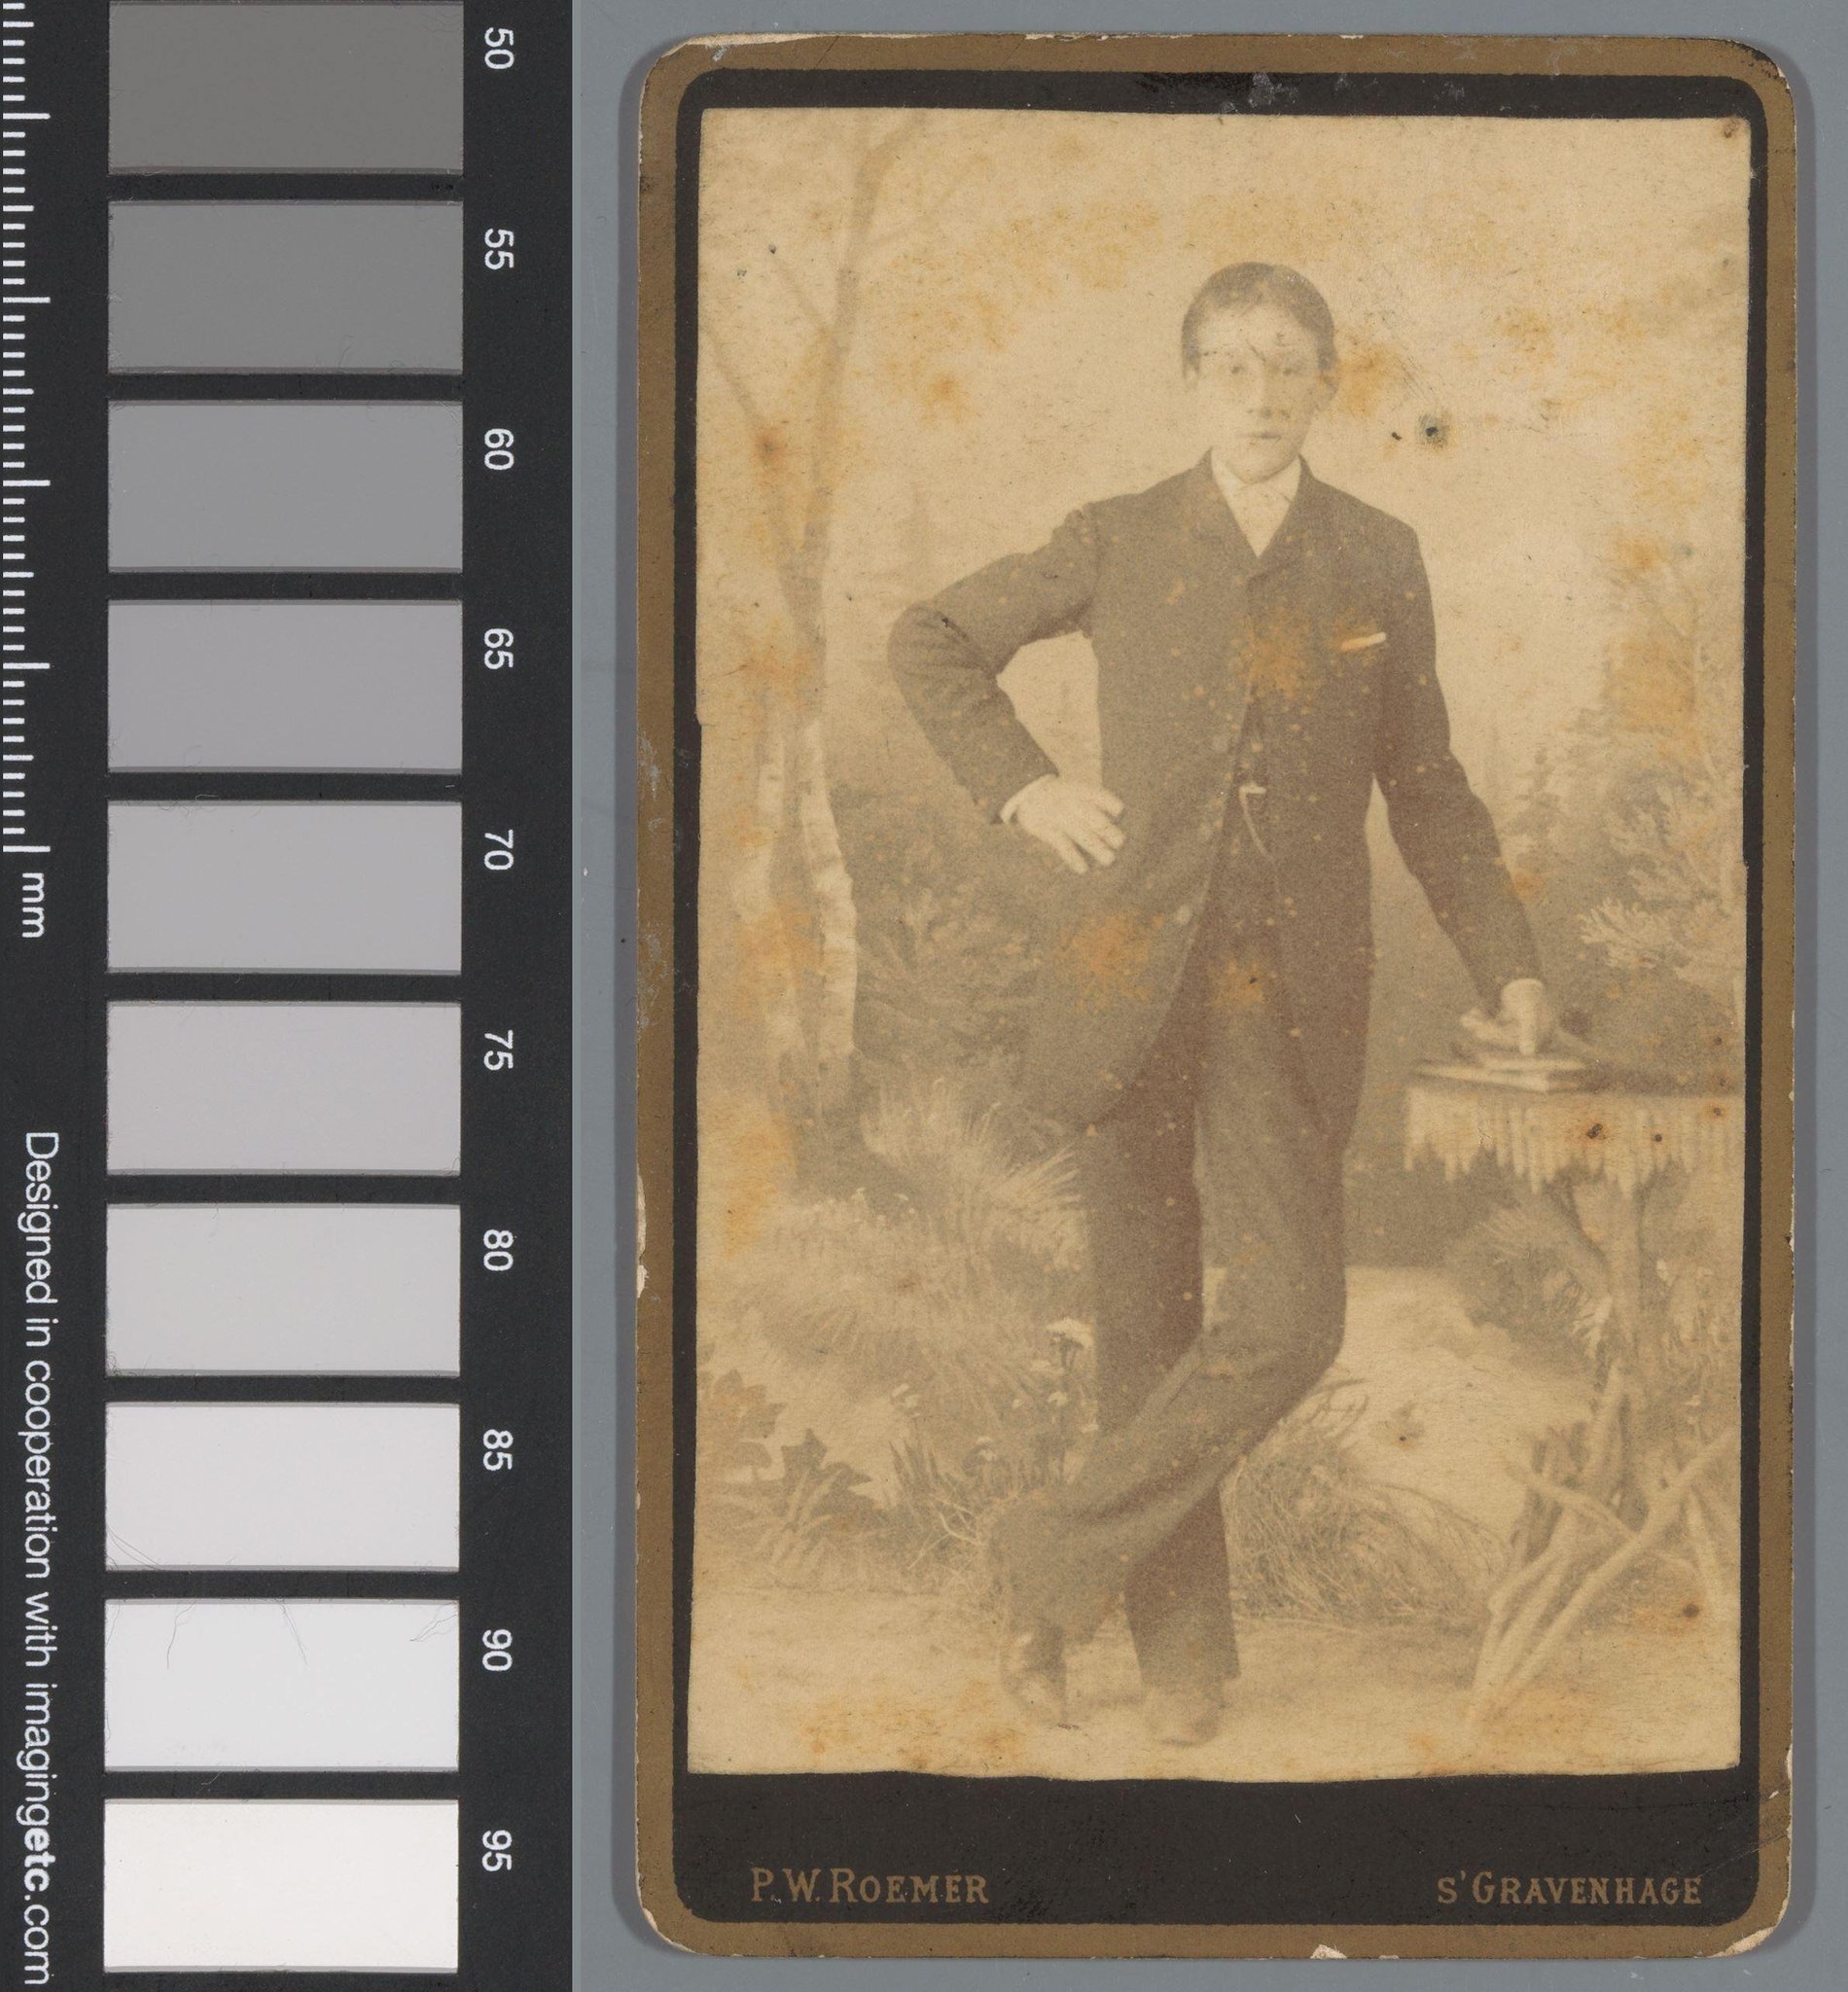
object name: carte de visite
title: Portret van een onbekende man, staande naast een tafel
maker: pieter wilhelmus roemer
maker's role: fotograaf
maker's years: 1838-1924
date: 1864-1910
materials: cardboard, paper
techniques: albumen print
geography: the hague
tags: historical persons, youth, adolescent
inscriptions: inscription: ‘PWR/ PHOTOGRAPHIE ARTISITQUE/ van/ P. W. ROEMER/ Passage No. 22/ bij de Spuistraat,/ S GRAVENHAGE./ Specialiteit van Vergrootingen./ De plaat blijft ter nabestelling bewaard.’